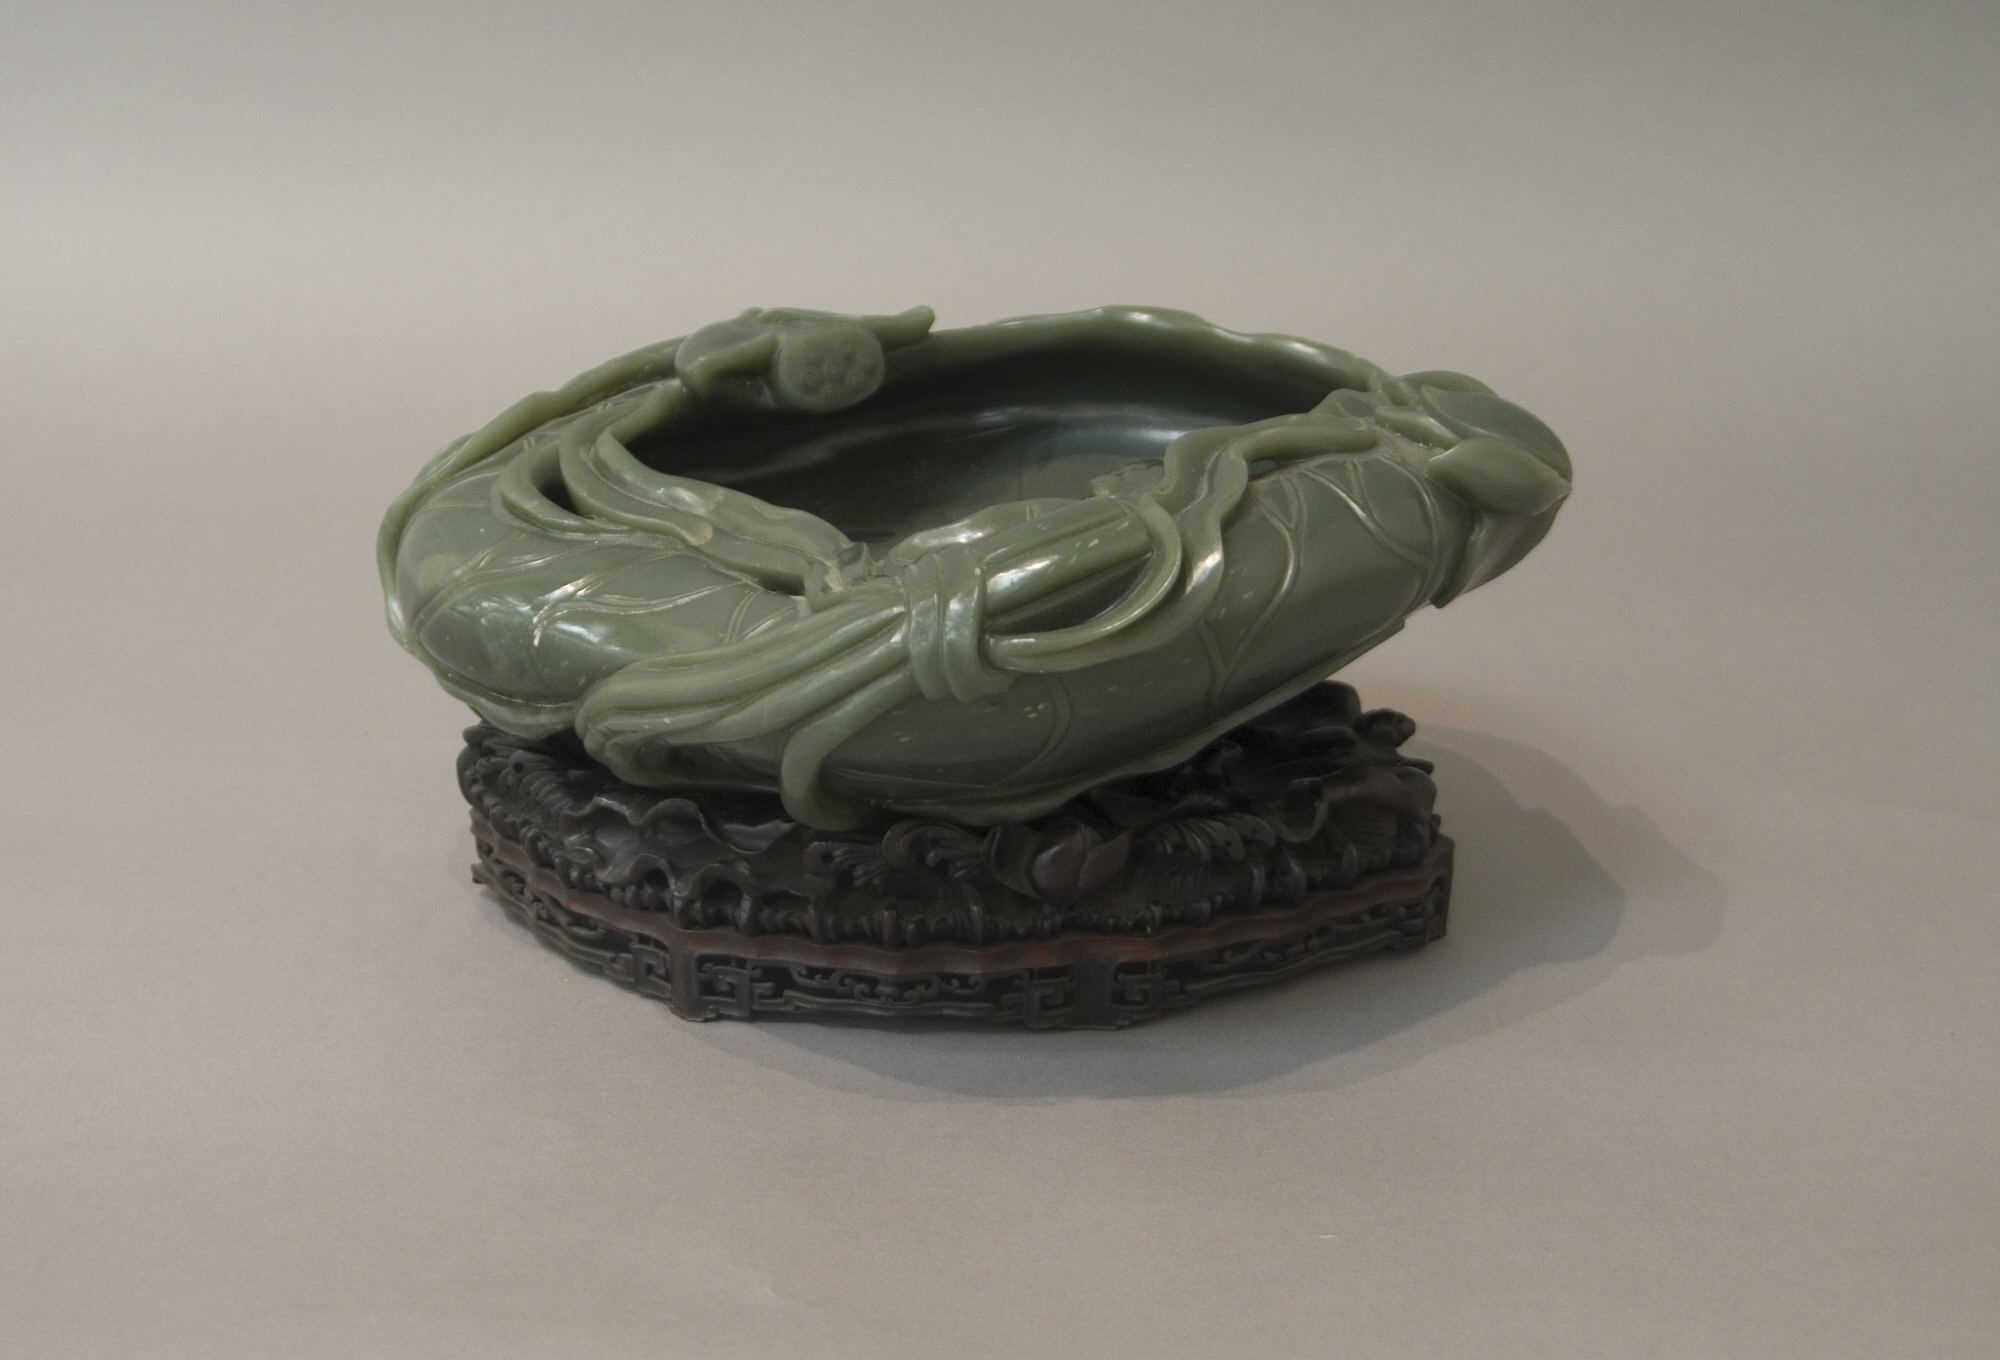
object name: dish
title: Lotus-Leaf Dish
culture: chinese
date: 1662-1722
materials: jade